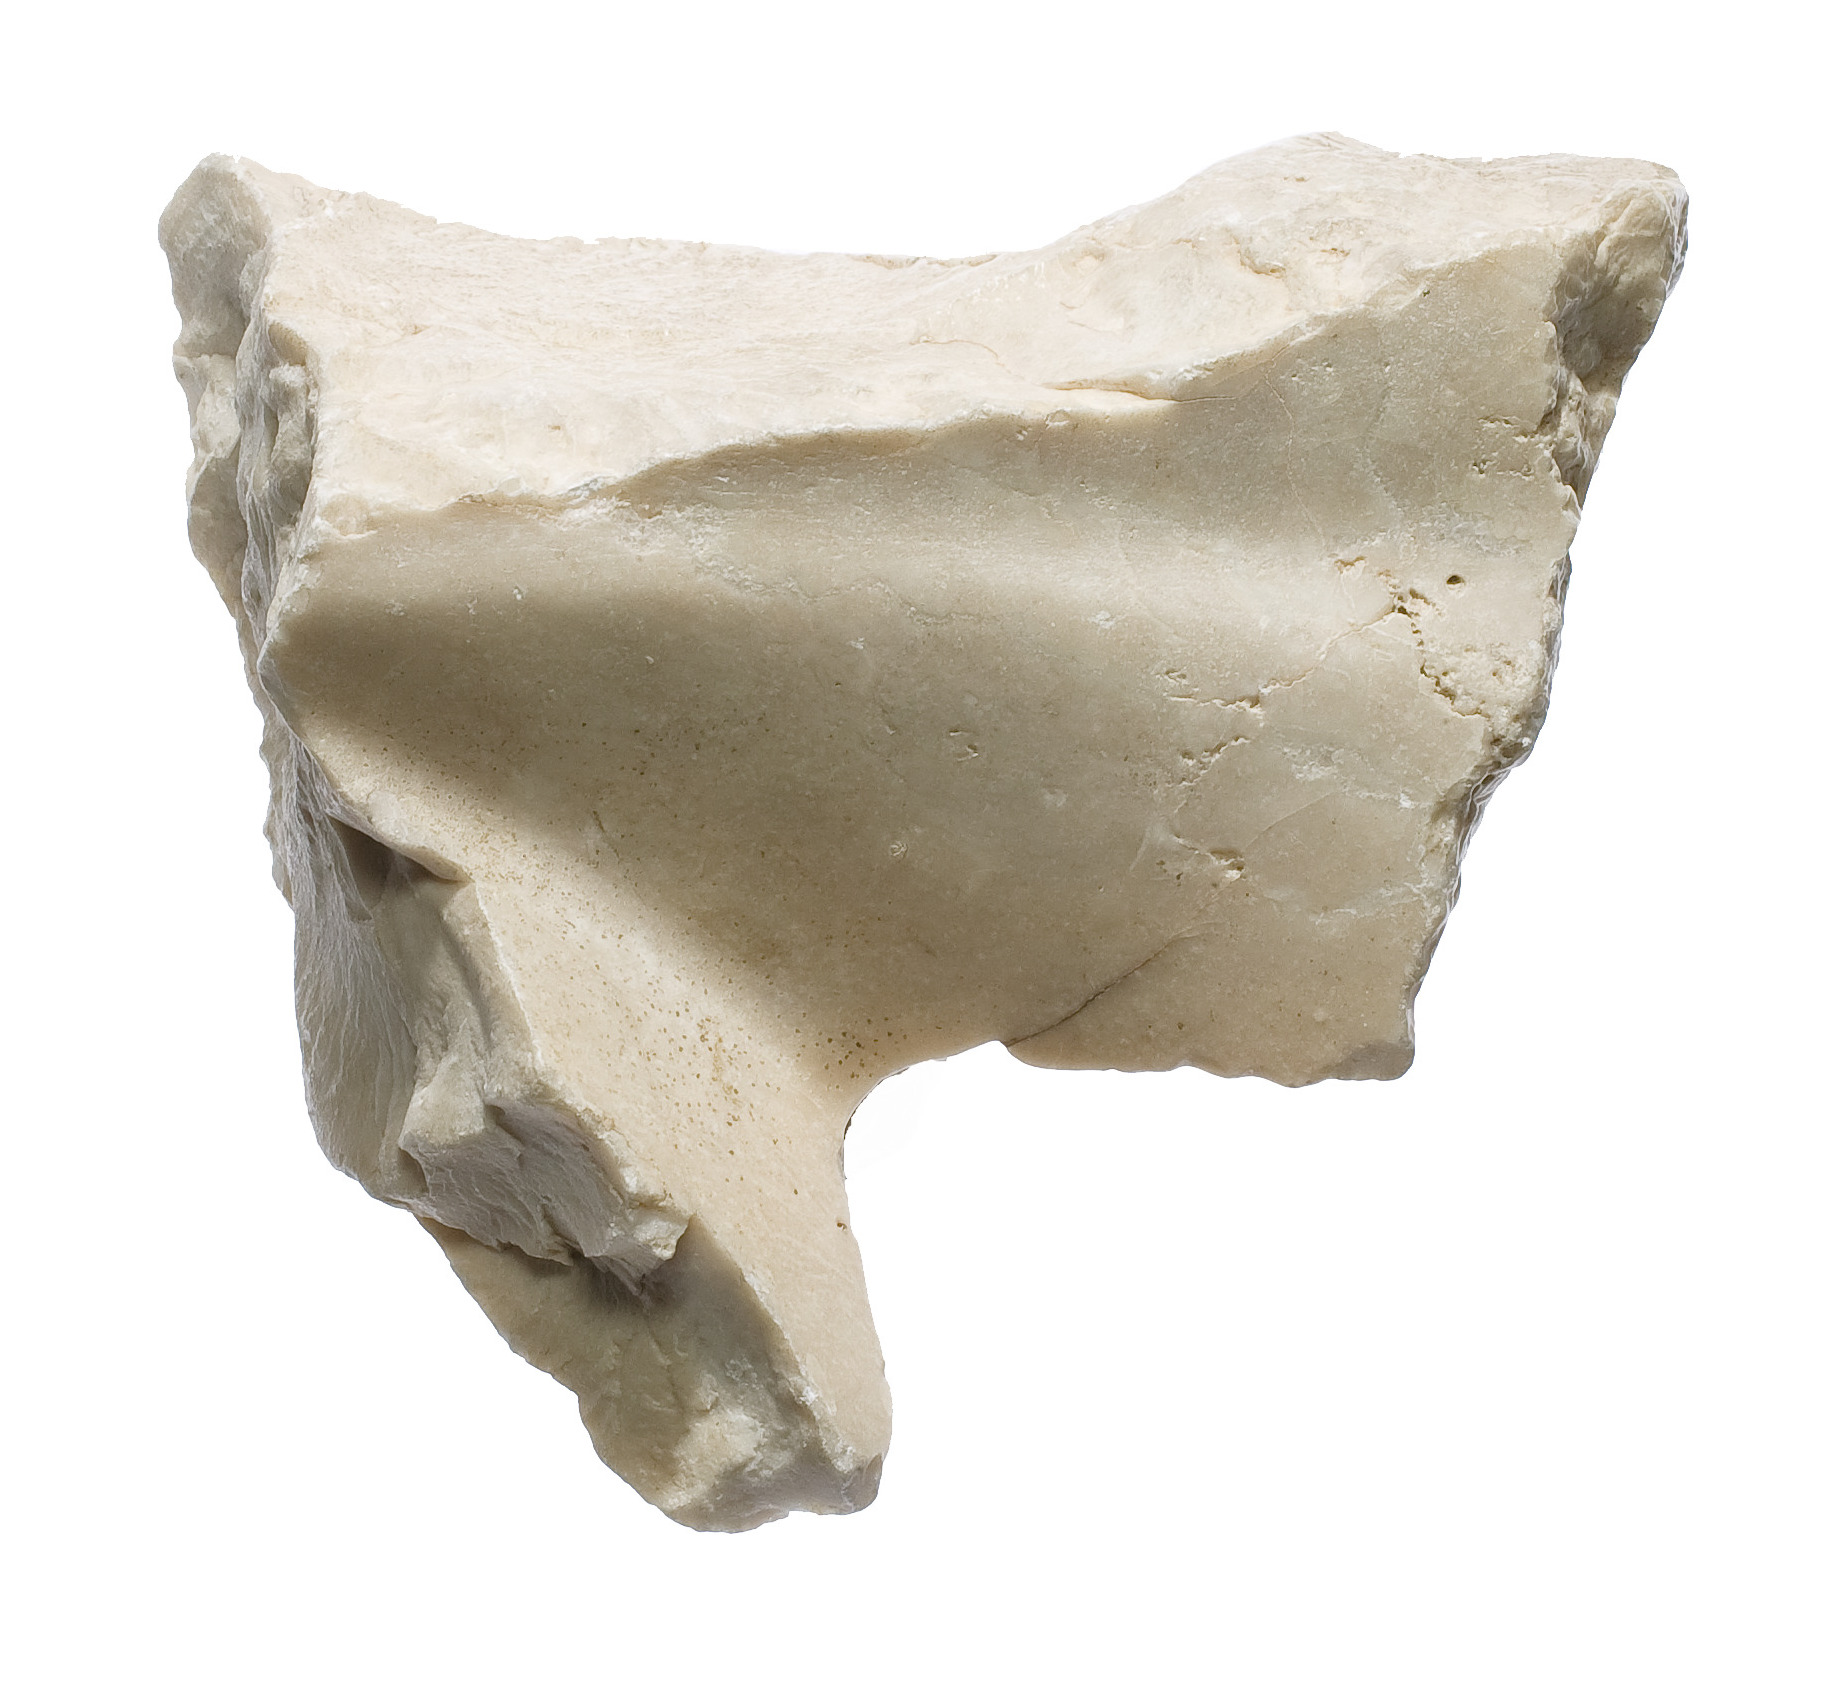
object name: foot and leg neck and chest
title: Foot and leg? neck and chest?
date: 1353-1336 BCE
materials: limestone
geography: egypt